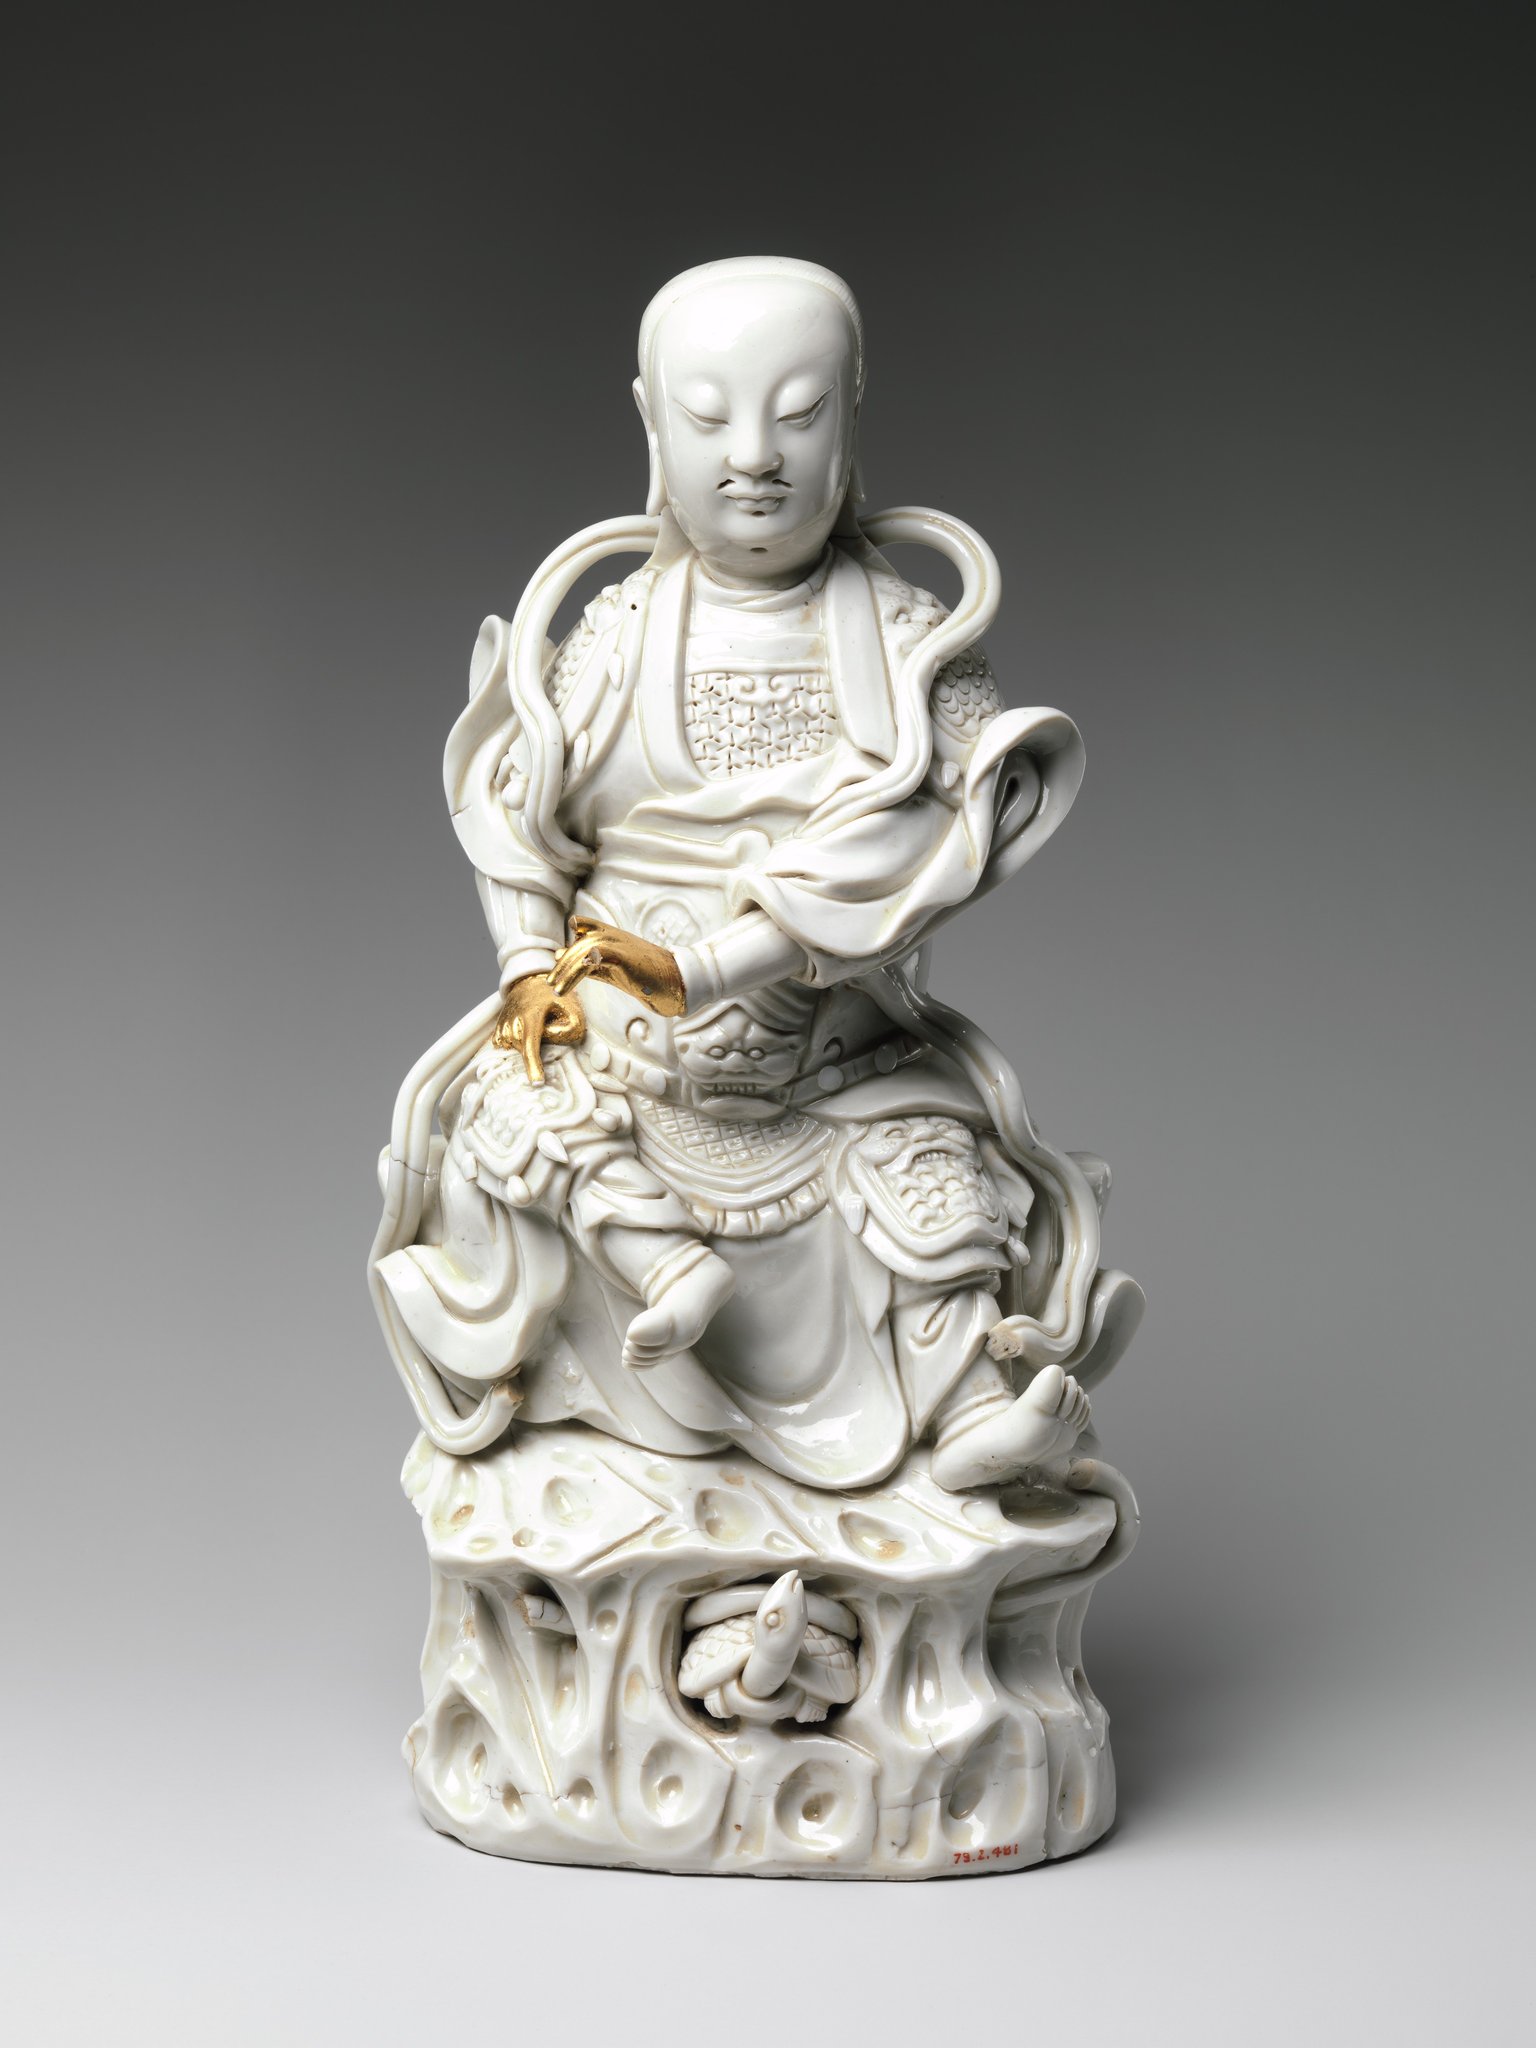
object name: figure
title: Daoist deity Zhenwu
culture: chinese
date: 1701-1733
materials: glaze, ivory, porcelain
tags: turtles,deities,daoism